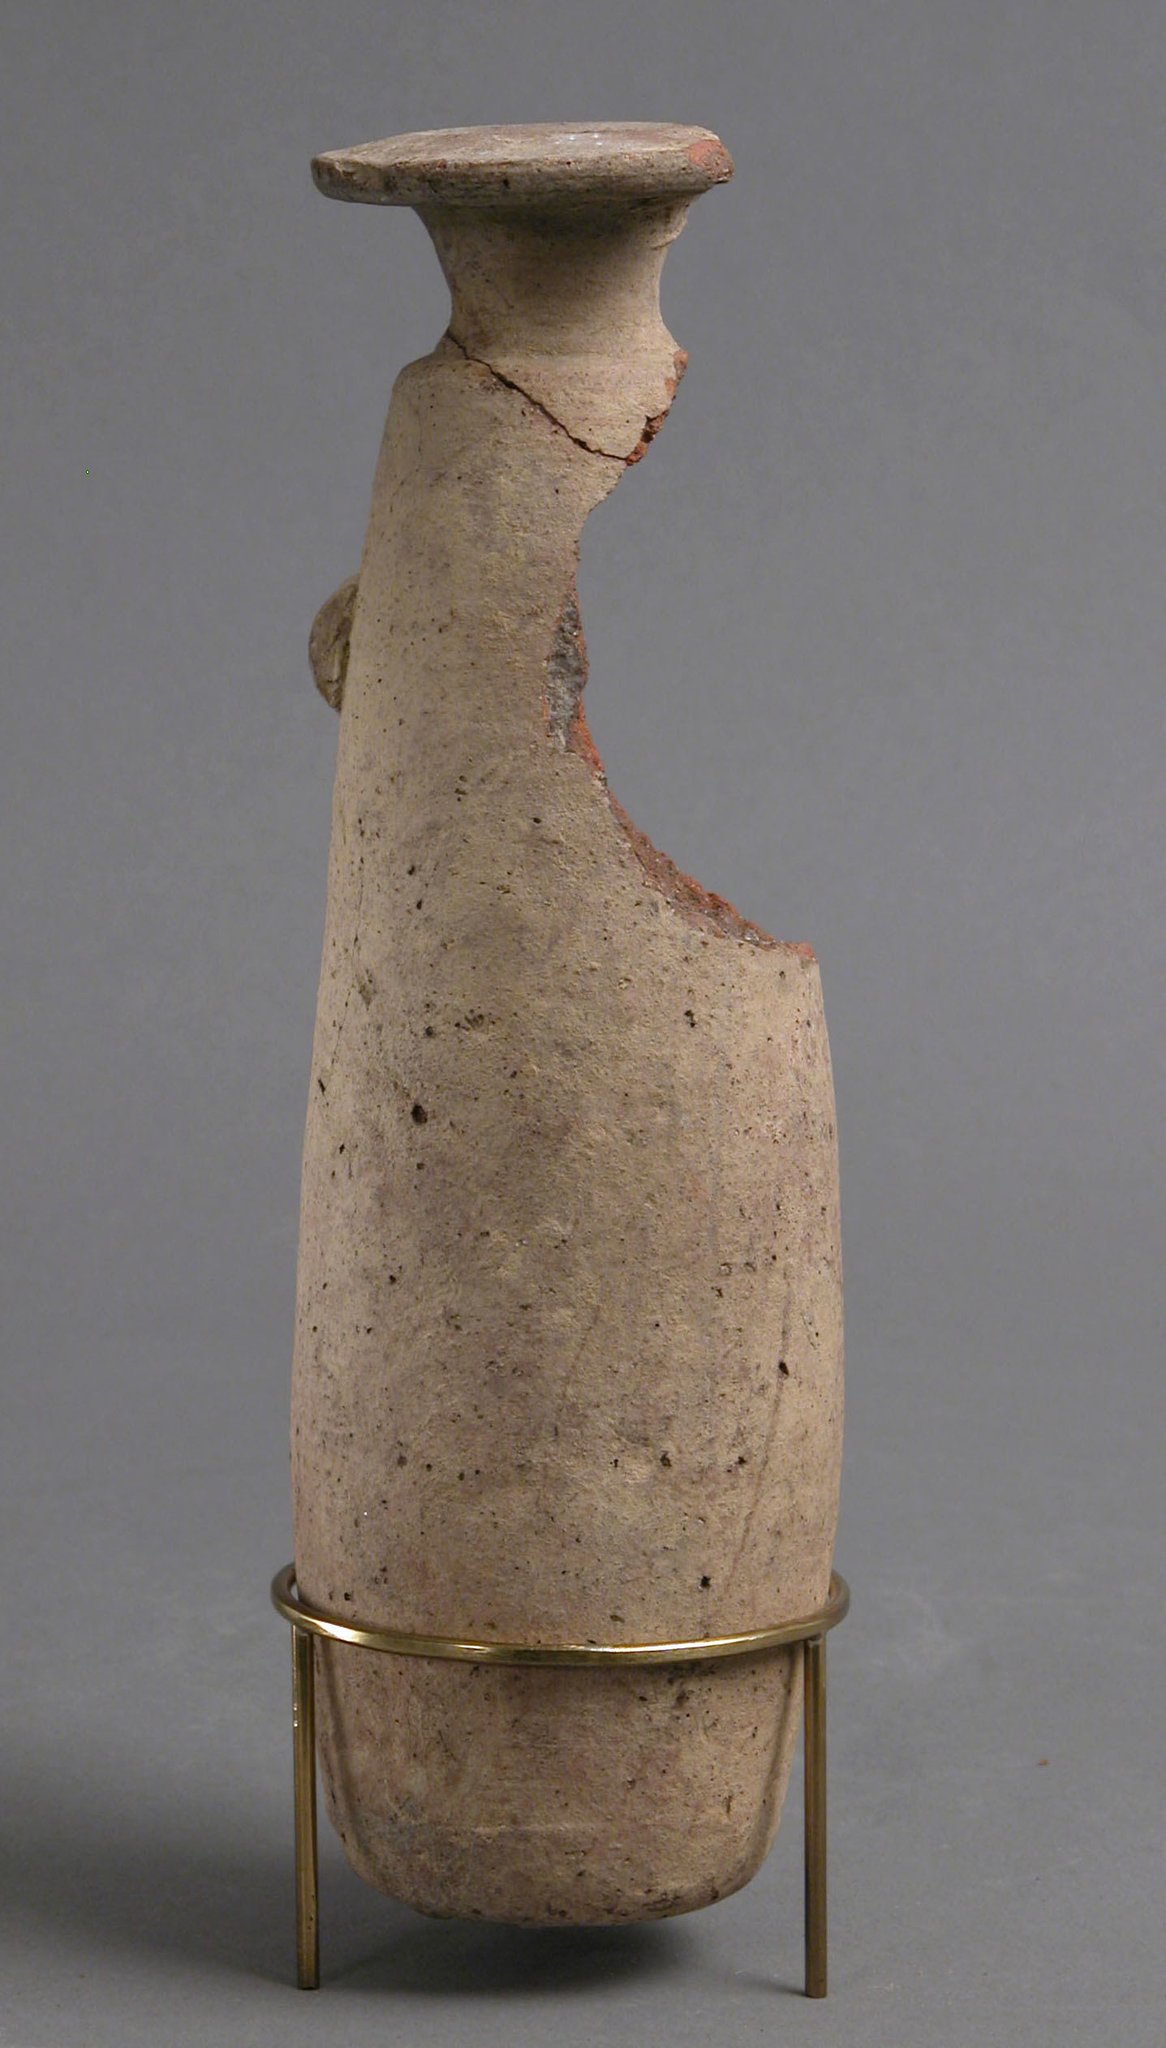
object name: jar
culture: coptic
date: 301-700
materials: earthenware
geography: egypt